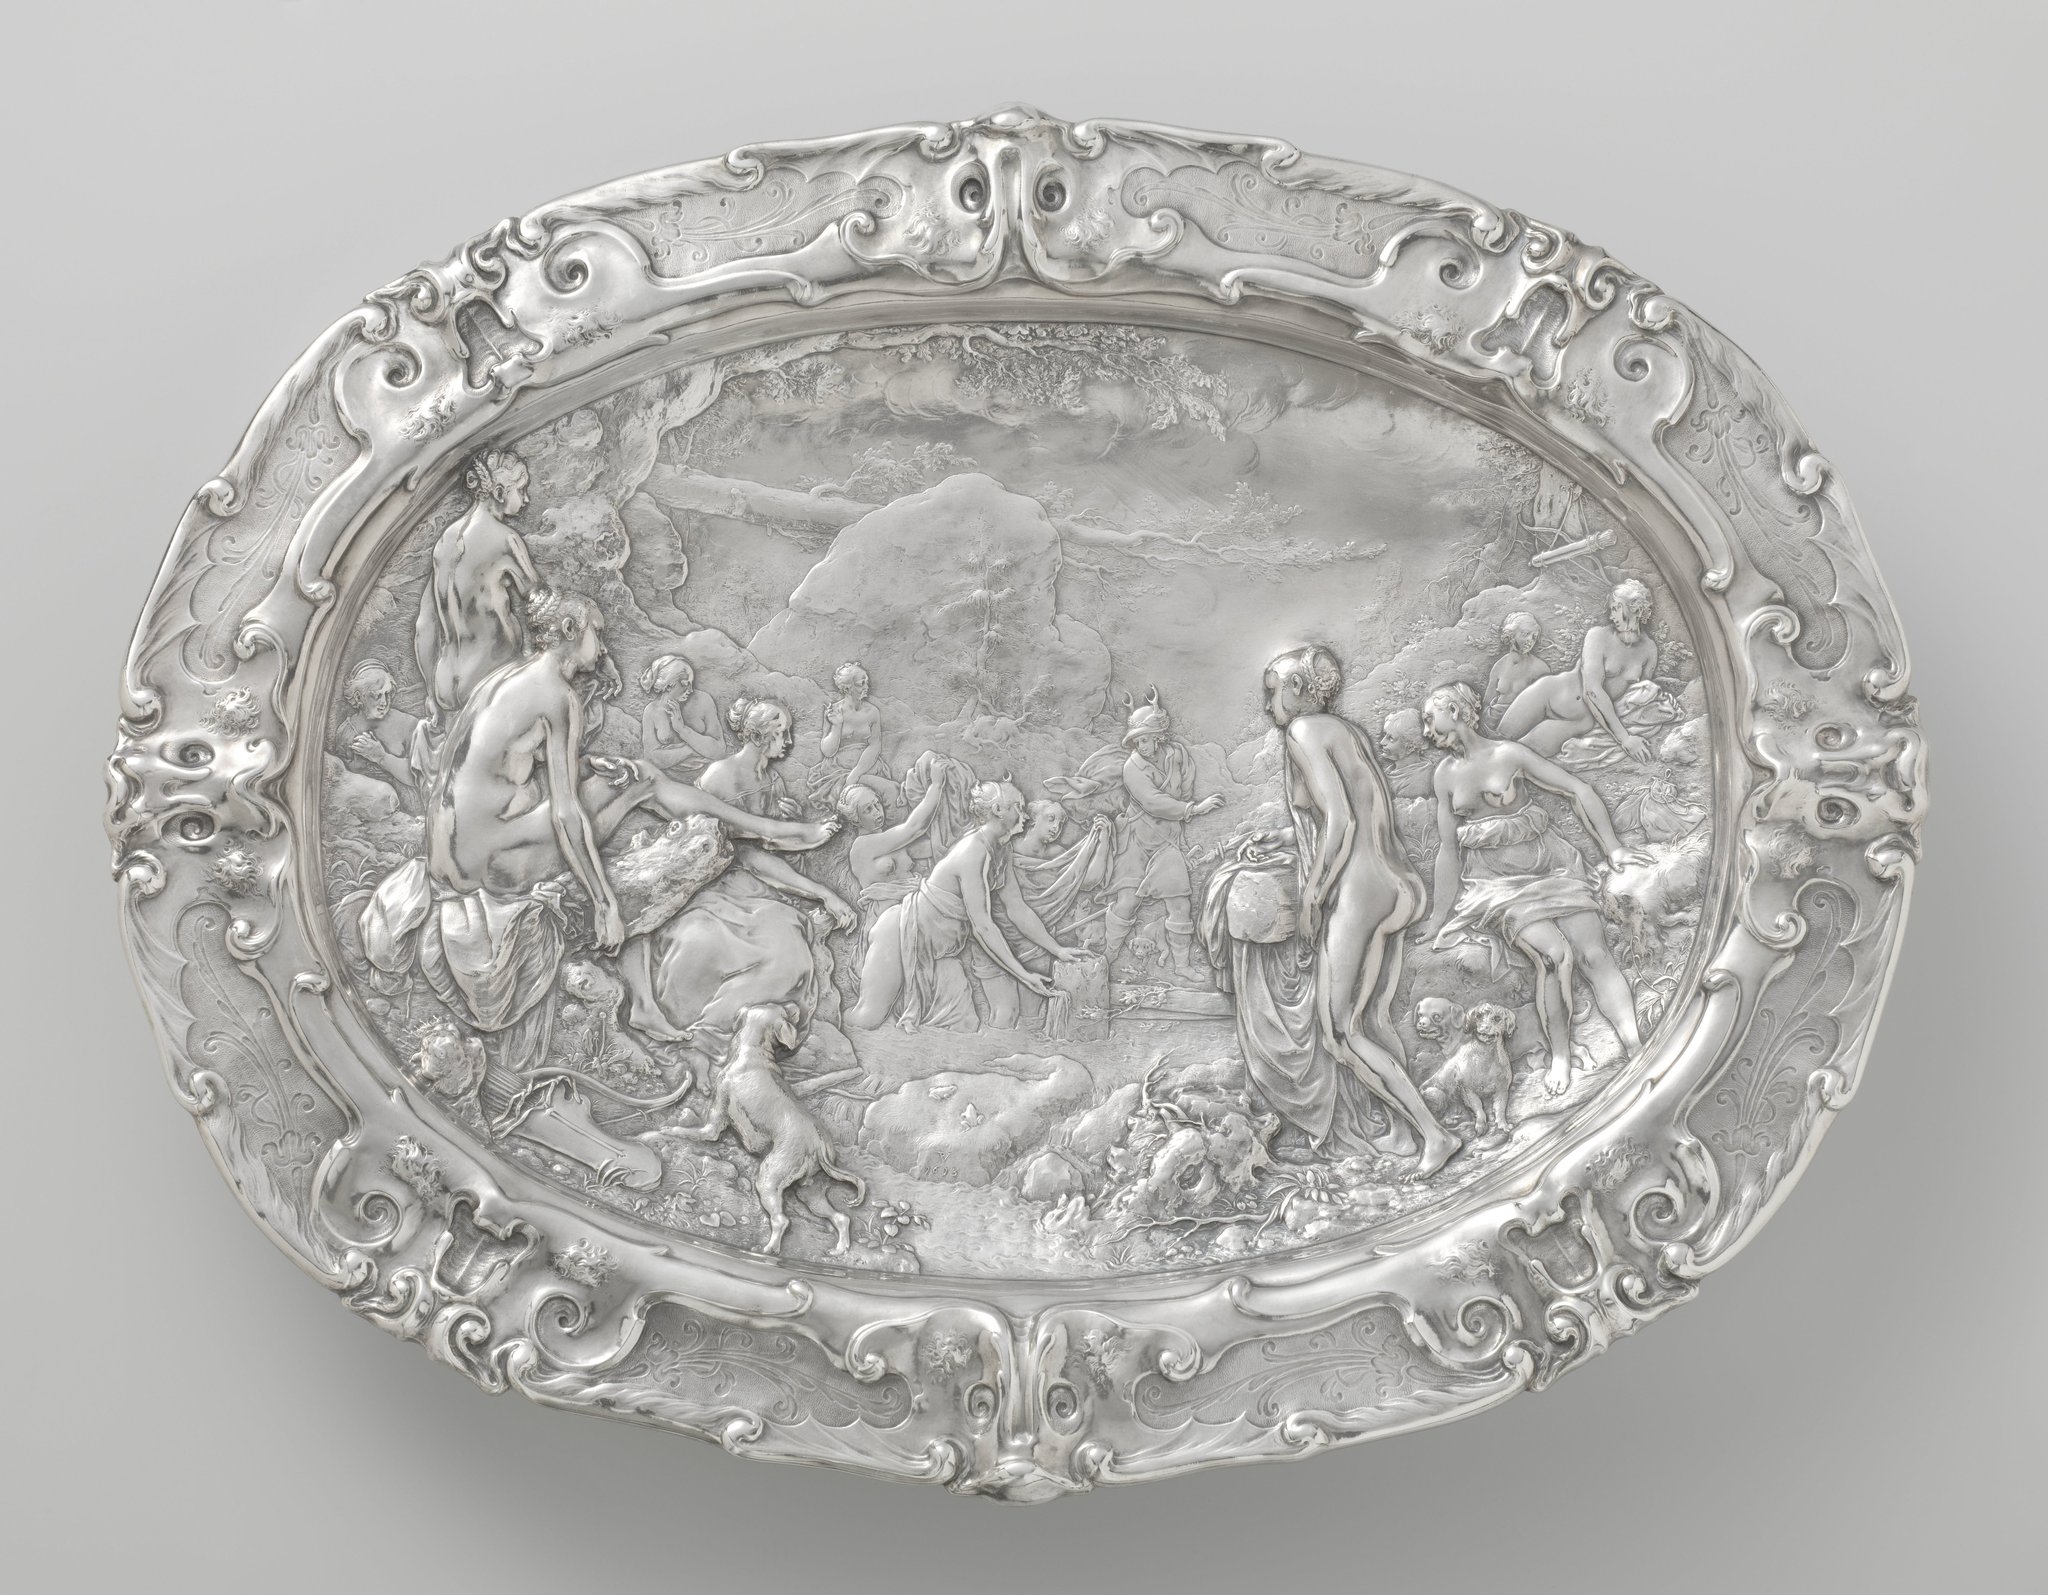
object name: dish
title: Basin with scenes from the story of Diana and Actaeon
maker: paulus willemsz. van vianen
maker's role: draughtsman, jeweler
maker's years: 1570-1614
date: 1613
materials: silver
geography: prague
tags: actaeon as a stag is devoured by his own dogs, actaeon changed into a stag: as punishment for seeing her bathe, diana changes actaeon, the hunter, into a stag (ovid, metamorphoses iii 193), mask, mascaron ~ ornament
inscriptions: monogram: ‘PV’, date: ‘1613’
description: While bathing with her nymphs, Diana is spied on by the hunter Actaeon. As no mortal may see the chaste goddess naked, Diana turns him into a stag. Here he is still shown in human form with antlers sprouting from his head. On the back of this basin is a depiction of Actaeon in the guise of a stag being torn to pieces by his own hounds.